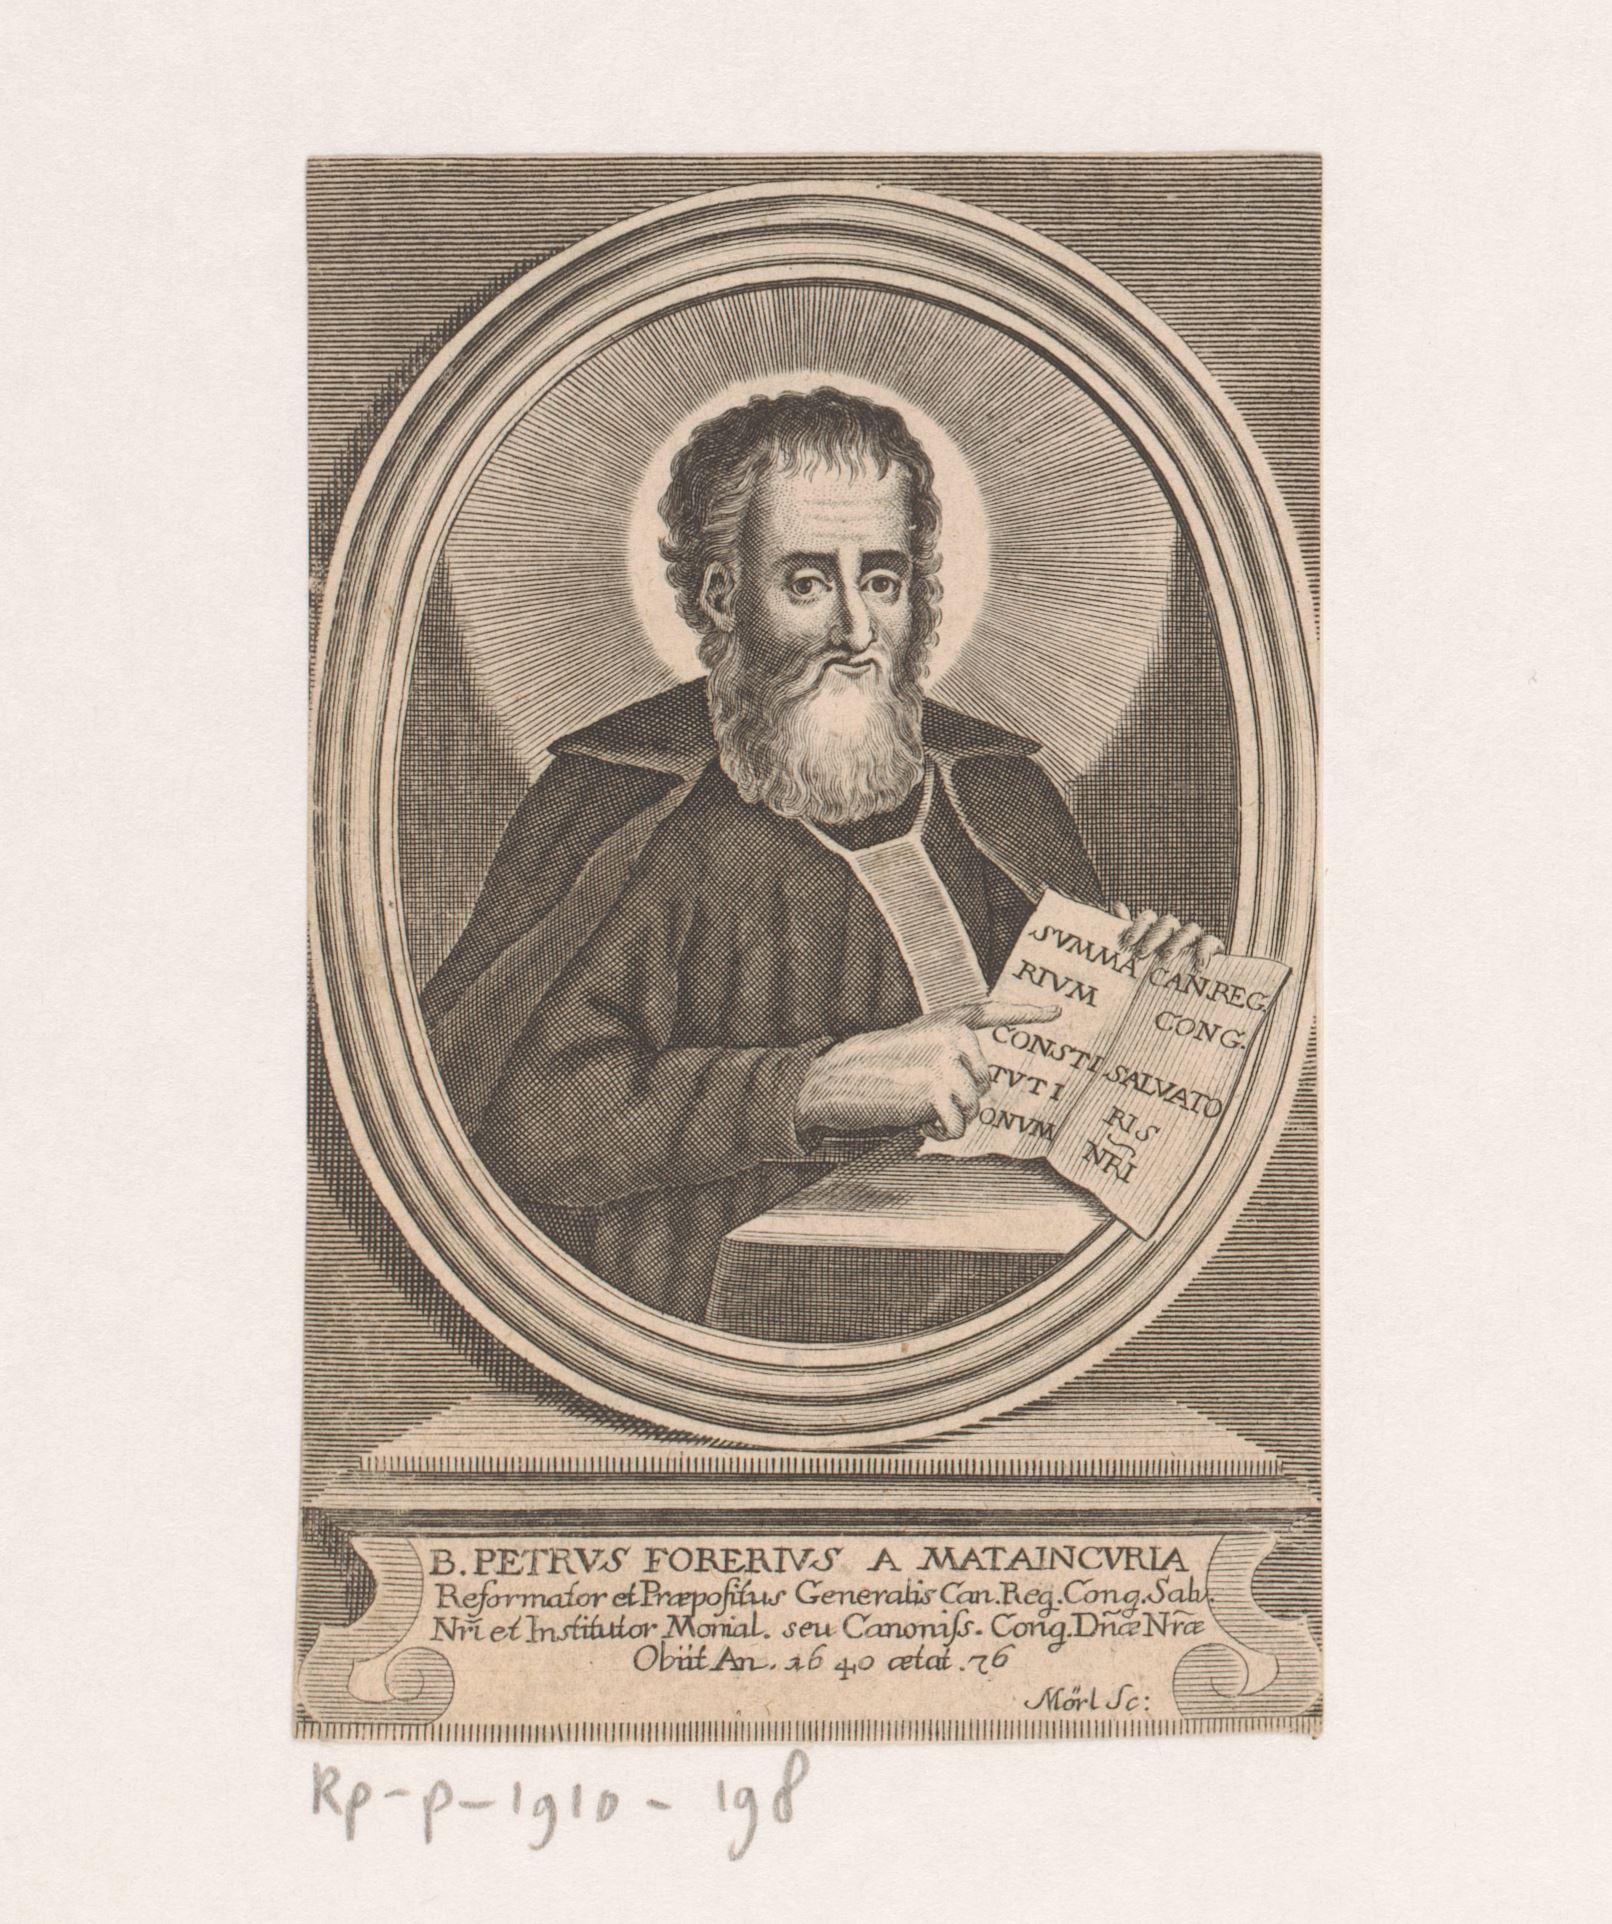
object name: print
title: Portret van Petrus Fourier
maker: joseph mörl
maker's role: print maker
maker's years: -1735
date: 1640-1735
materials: paper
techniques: engraving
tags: priest, nimbus, halo ~ radiance emanating from persons or things, theologian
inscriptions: collector's mark: Lugt 2228